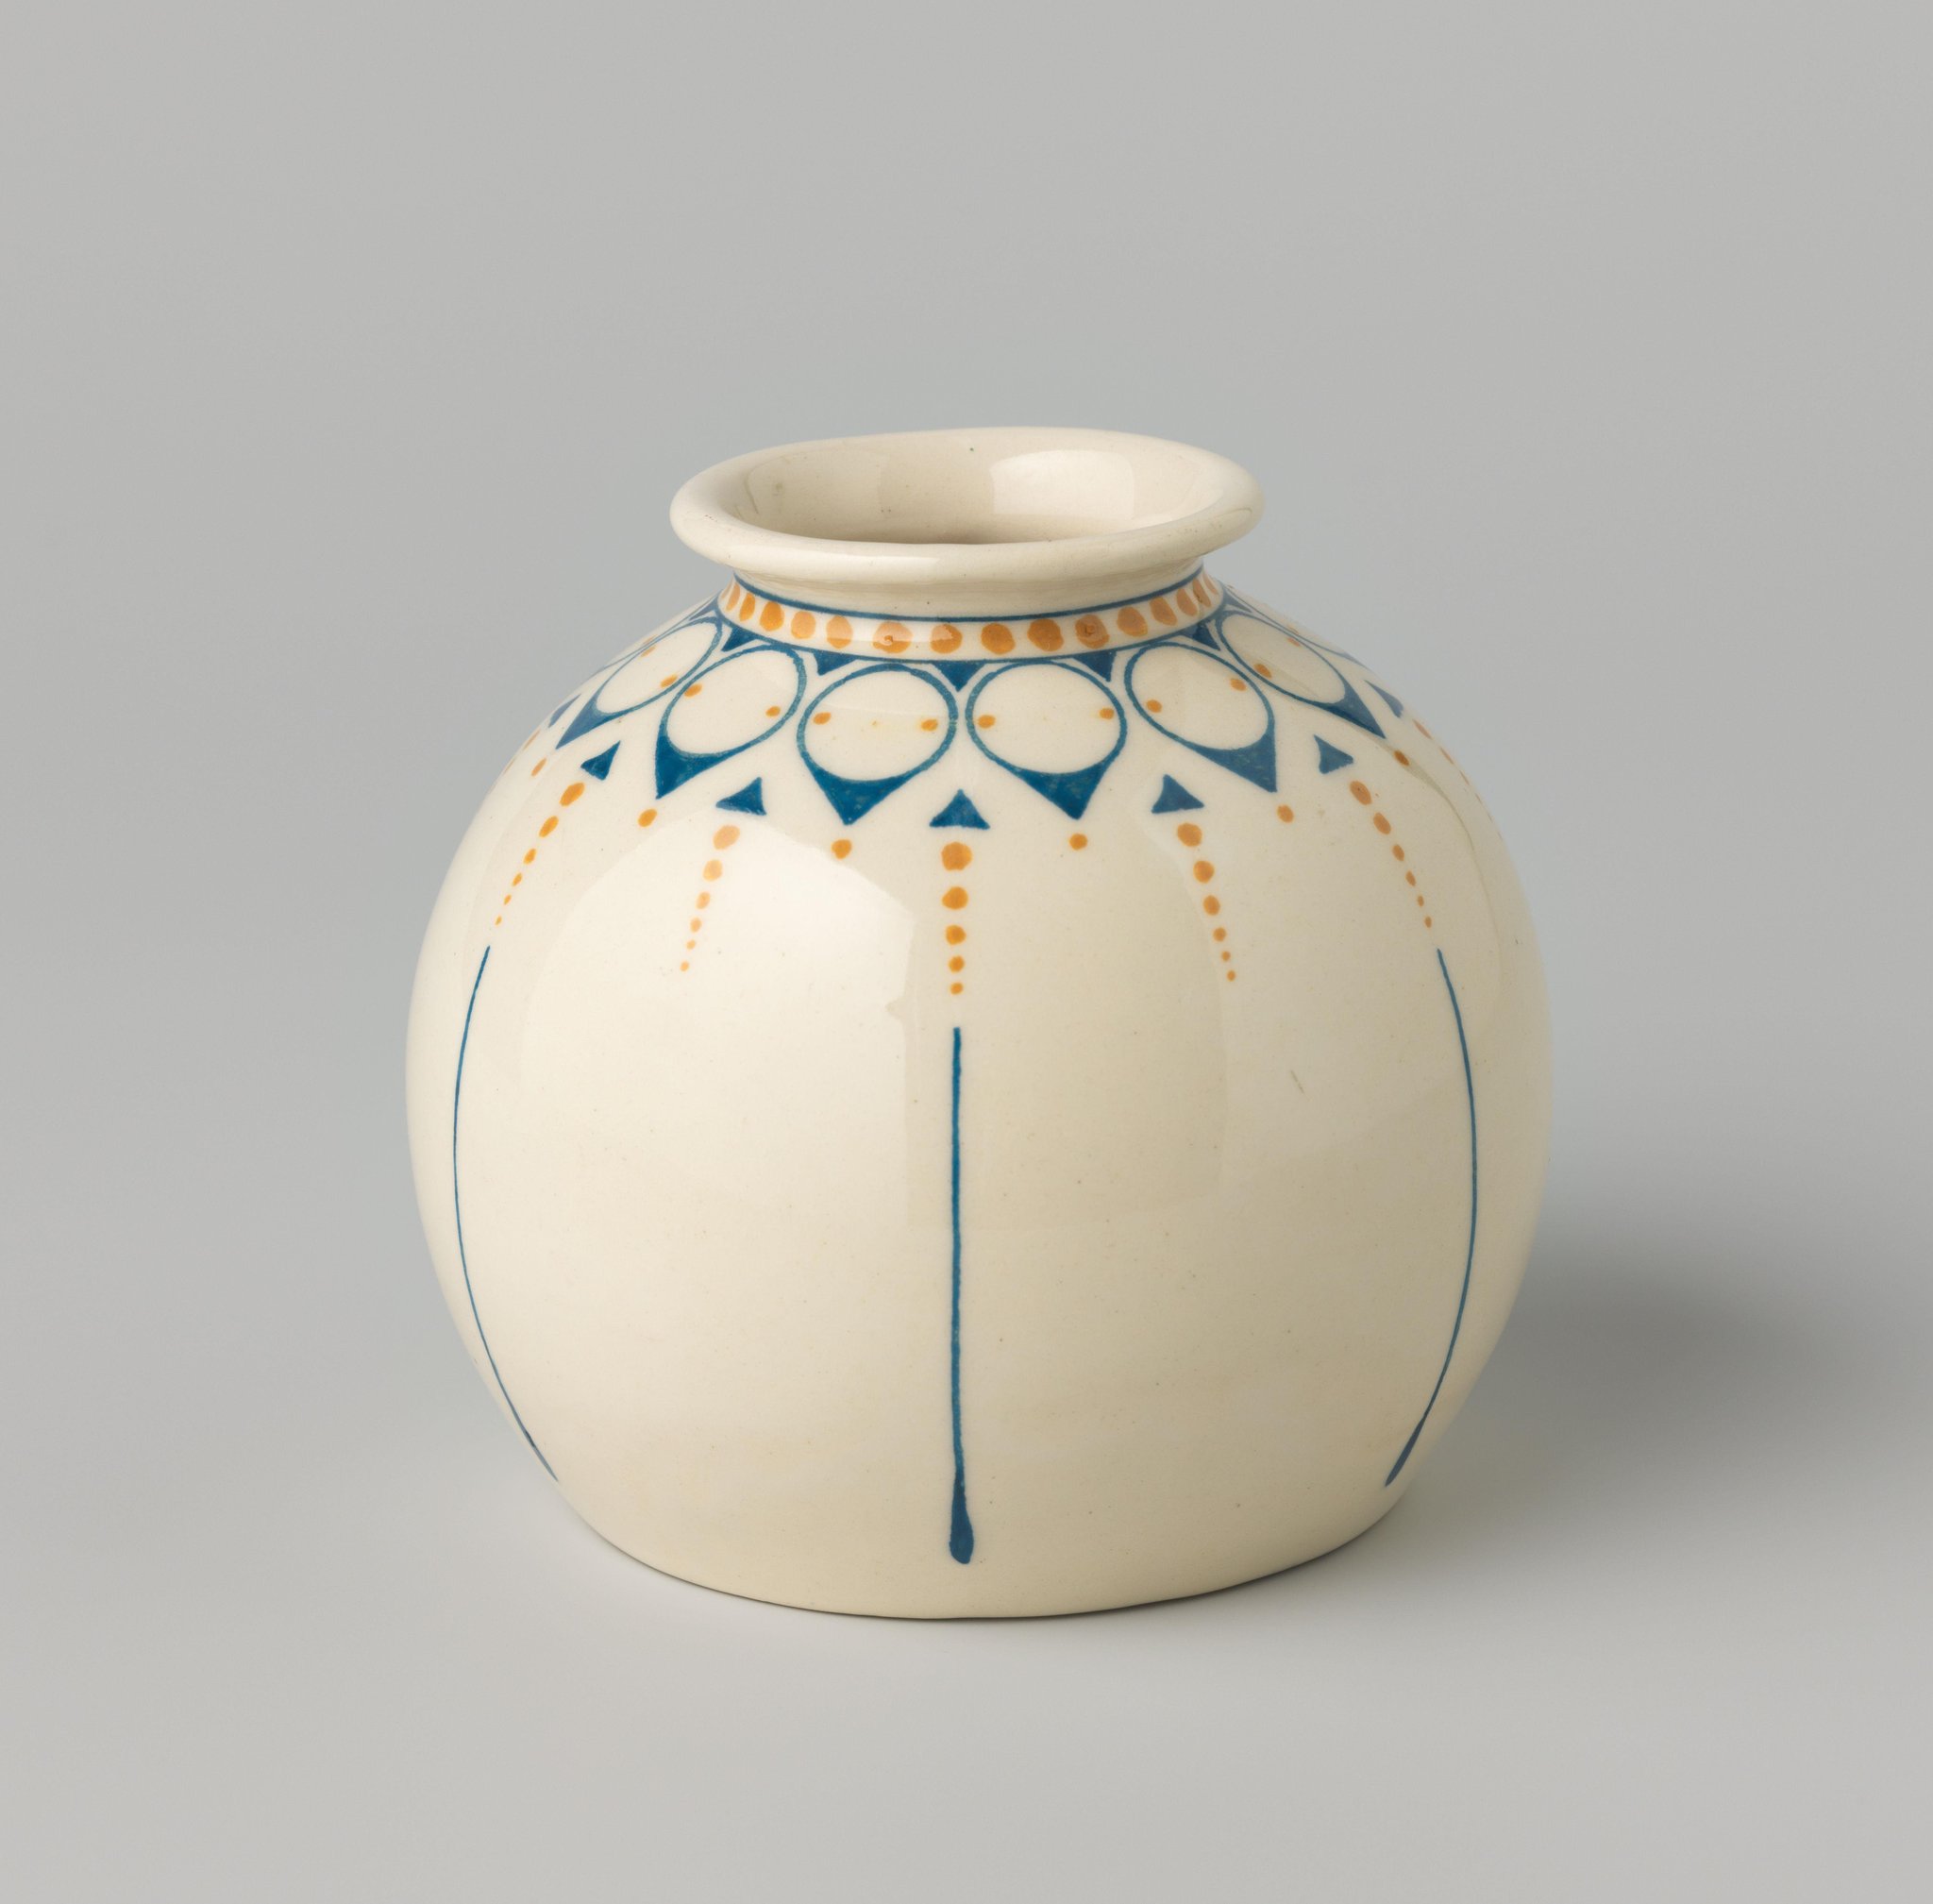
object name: vase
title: Vaas met geometrisch ornament in blauw en geel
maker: theodorus verstraaten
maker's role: painter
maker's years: 1872-1945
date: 1910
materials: earthenware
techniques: painted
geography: oegstgeest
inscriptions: mark: ‘AMPHORA // HOLLAND 217.3 L, ontw: T. VERSTRAATEN. Ingekrast: 217.’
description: Vaas van aardewerk, beschilderd in blauw en geel met geometrich ornament.